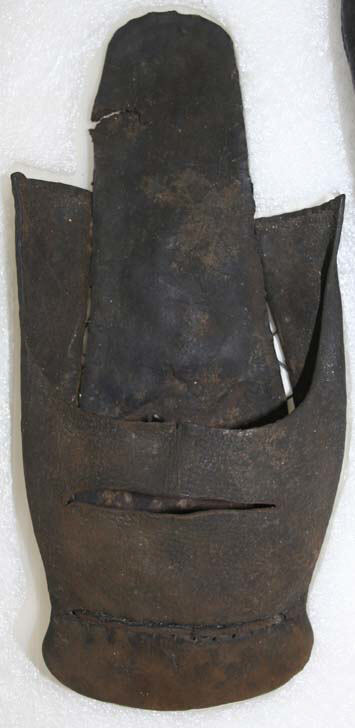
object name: shoe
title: Shoes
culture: british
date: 1501-1600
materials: leather